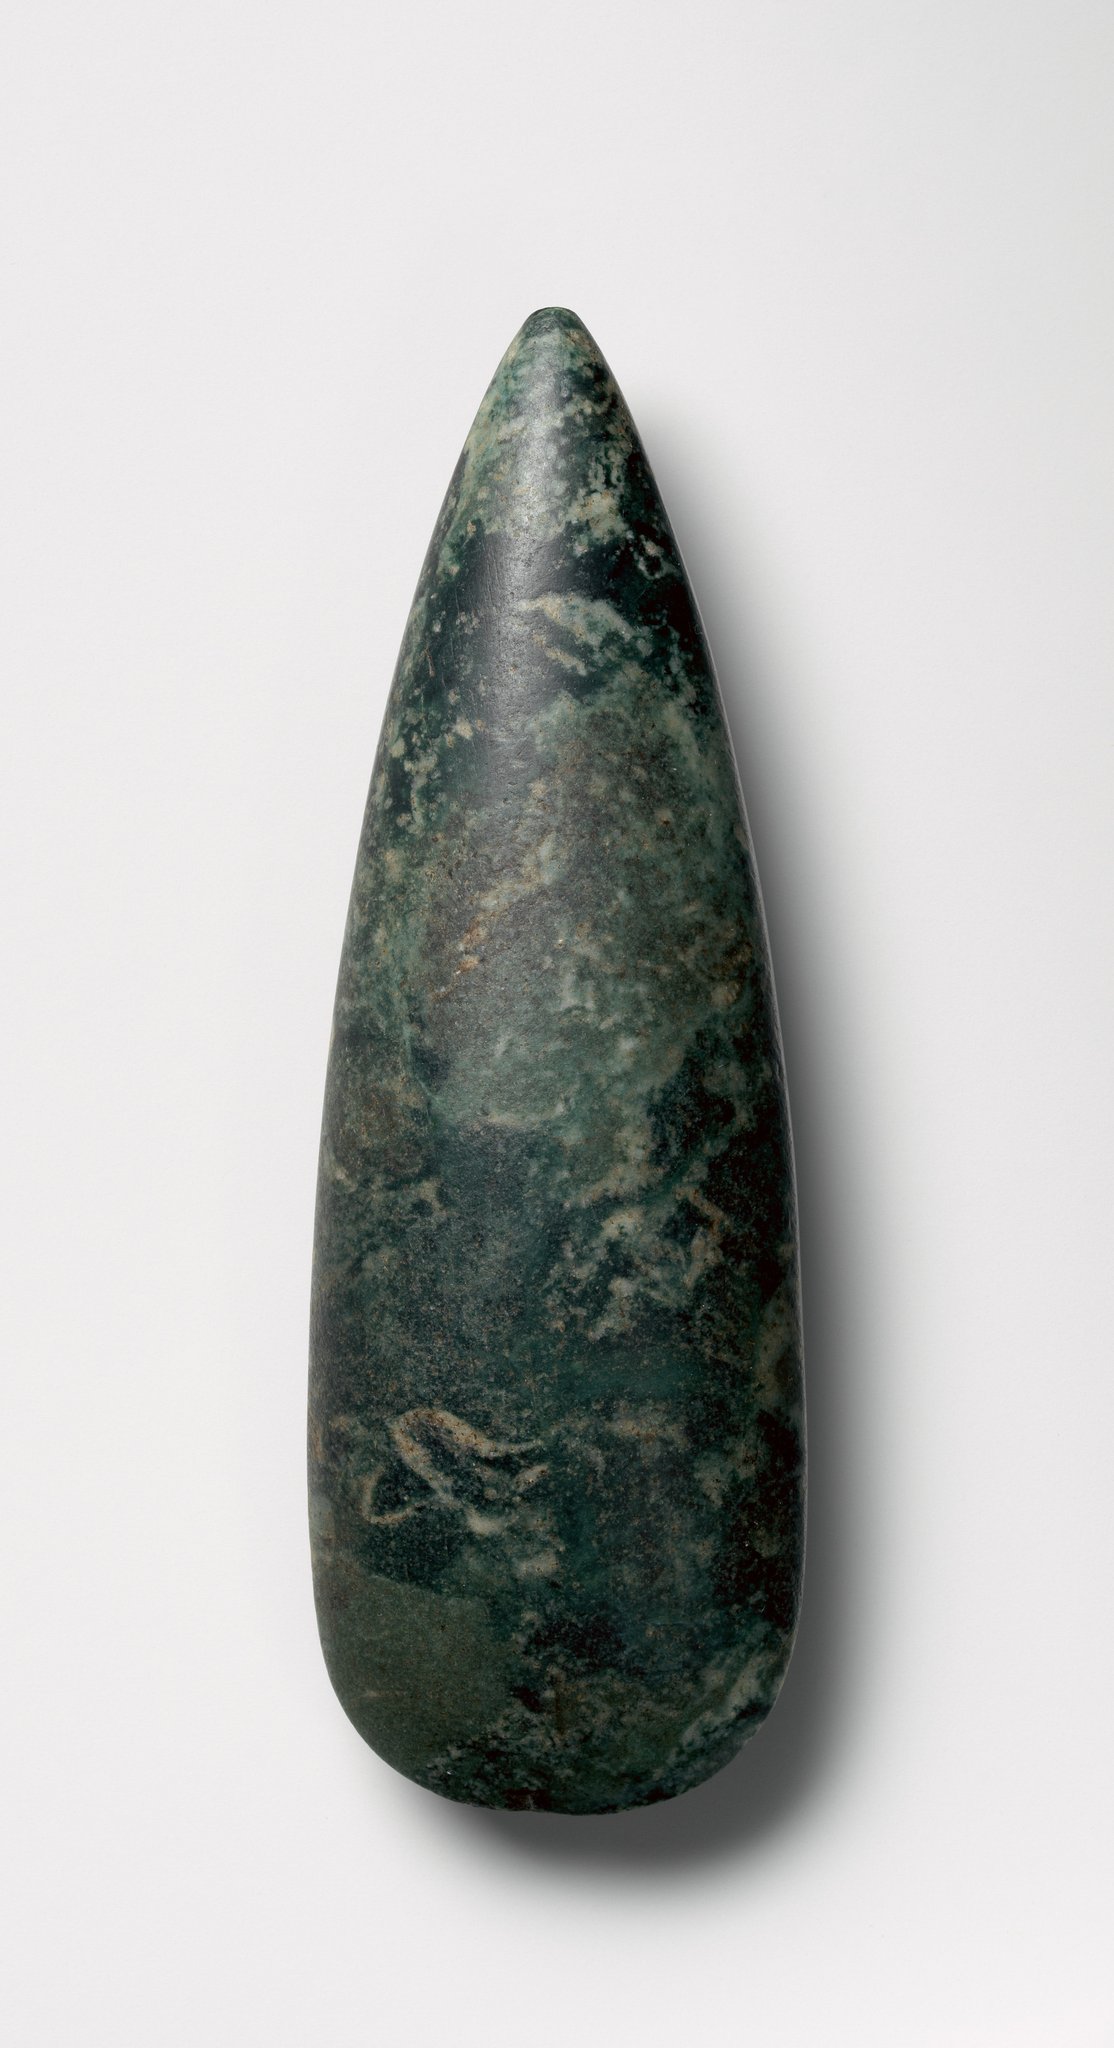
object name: celt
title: Ceremonial axe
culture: taíno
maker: taíno artist(s)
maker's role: artist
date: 600-1500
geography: dominican republic